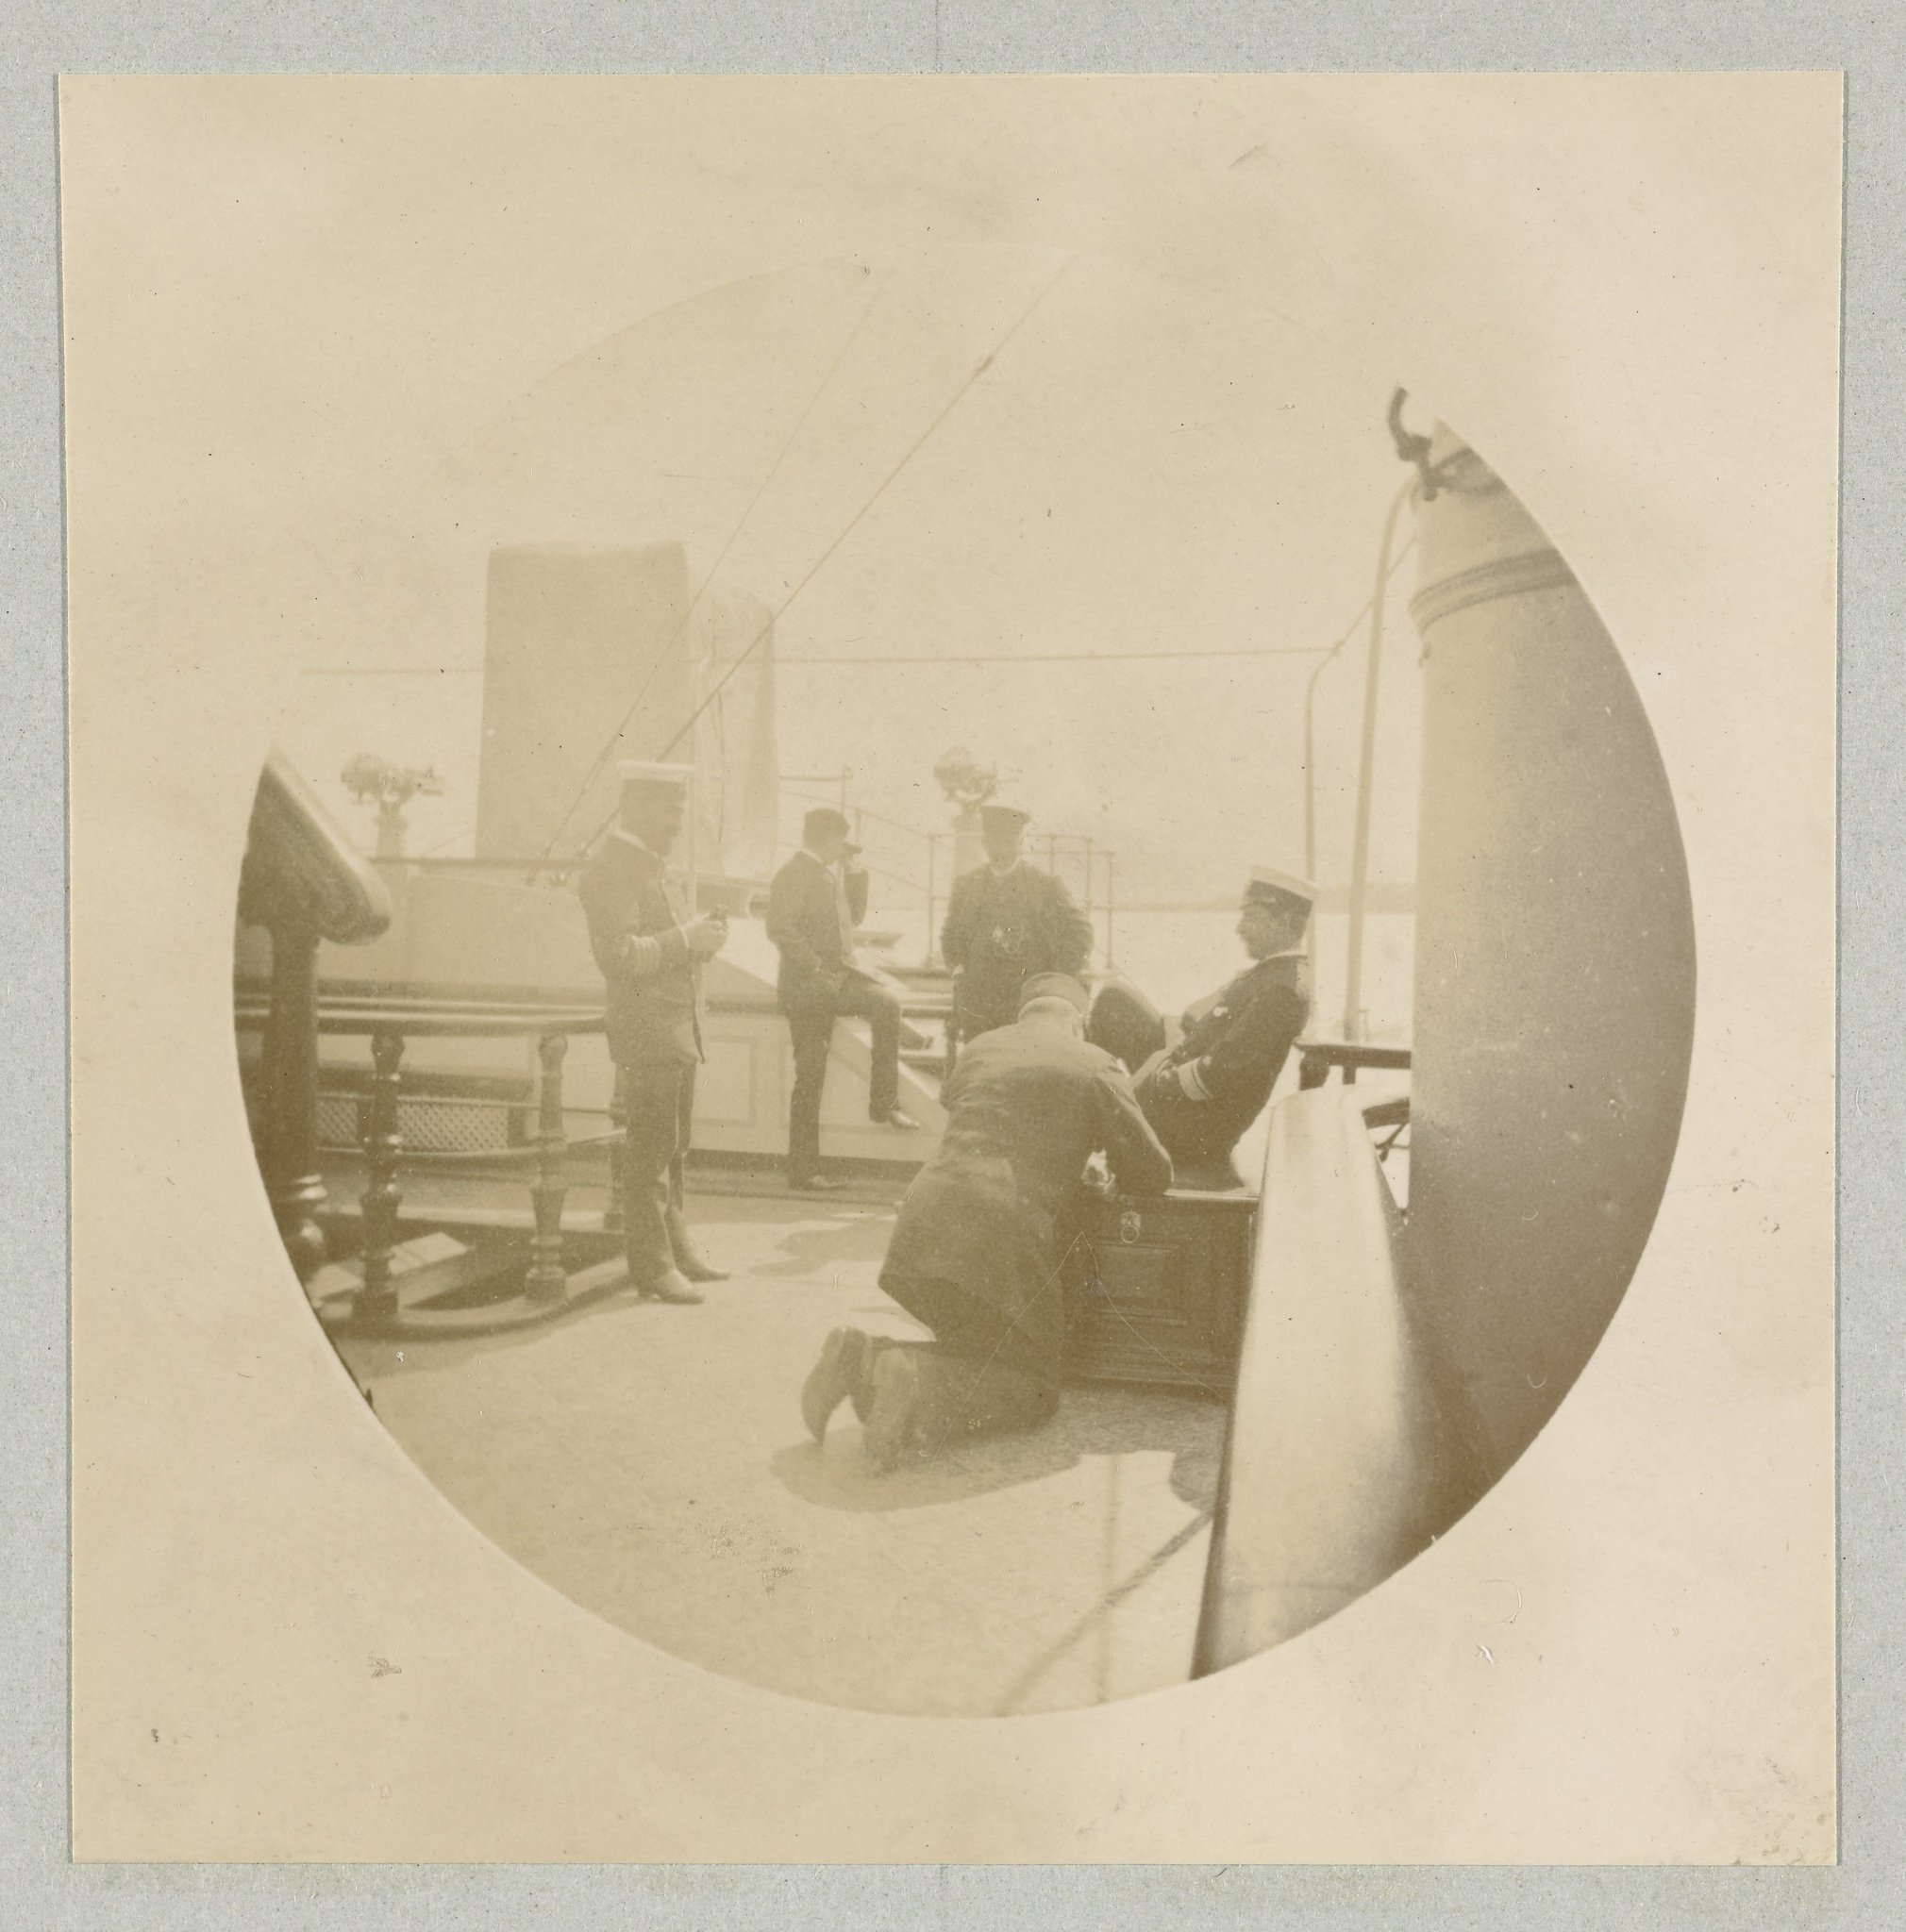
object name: photograph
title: Mannen in uniform aan boord van de Hohenzollern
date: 1807-1889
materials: cardboard, paper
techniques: gelatin silver print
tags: wilhelm ii (keizer van duitsland), norway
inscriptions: number: ‘23’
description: De afdruk van de foto is rond, het papier vierkant. foto gemaakt met Nr. 1 Kodak Camera